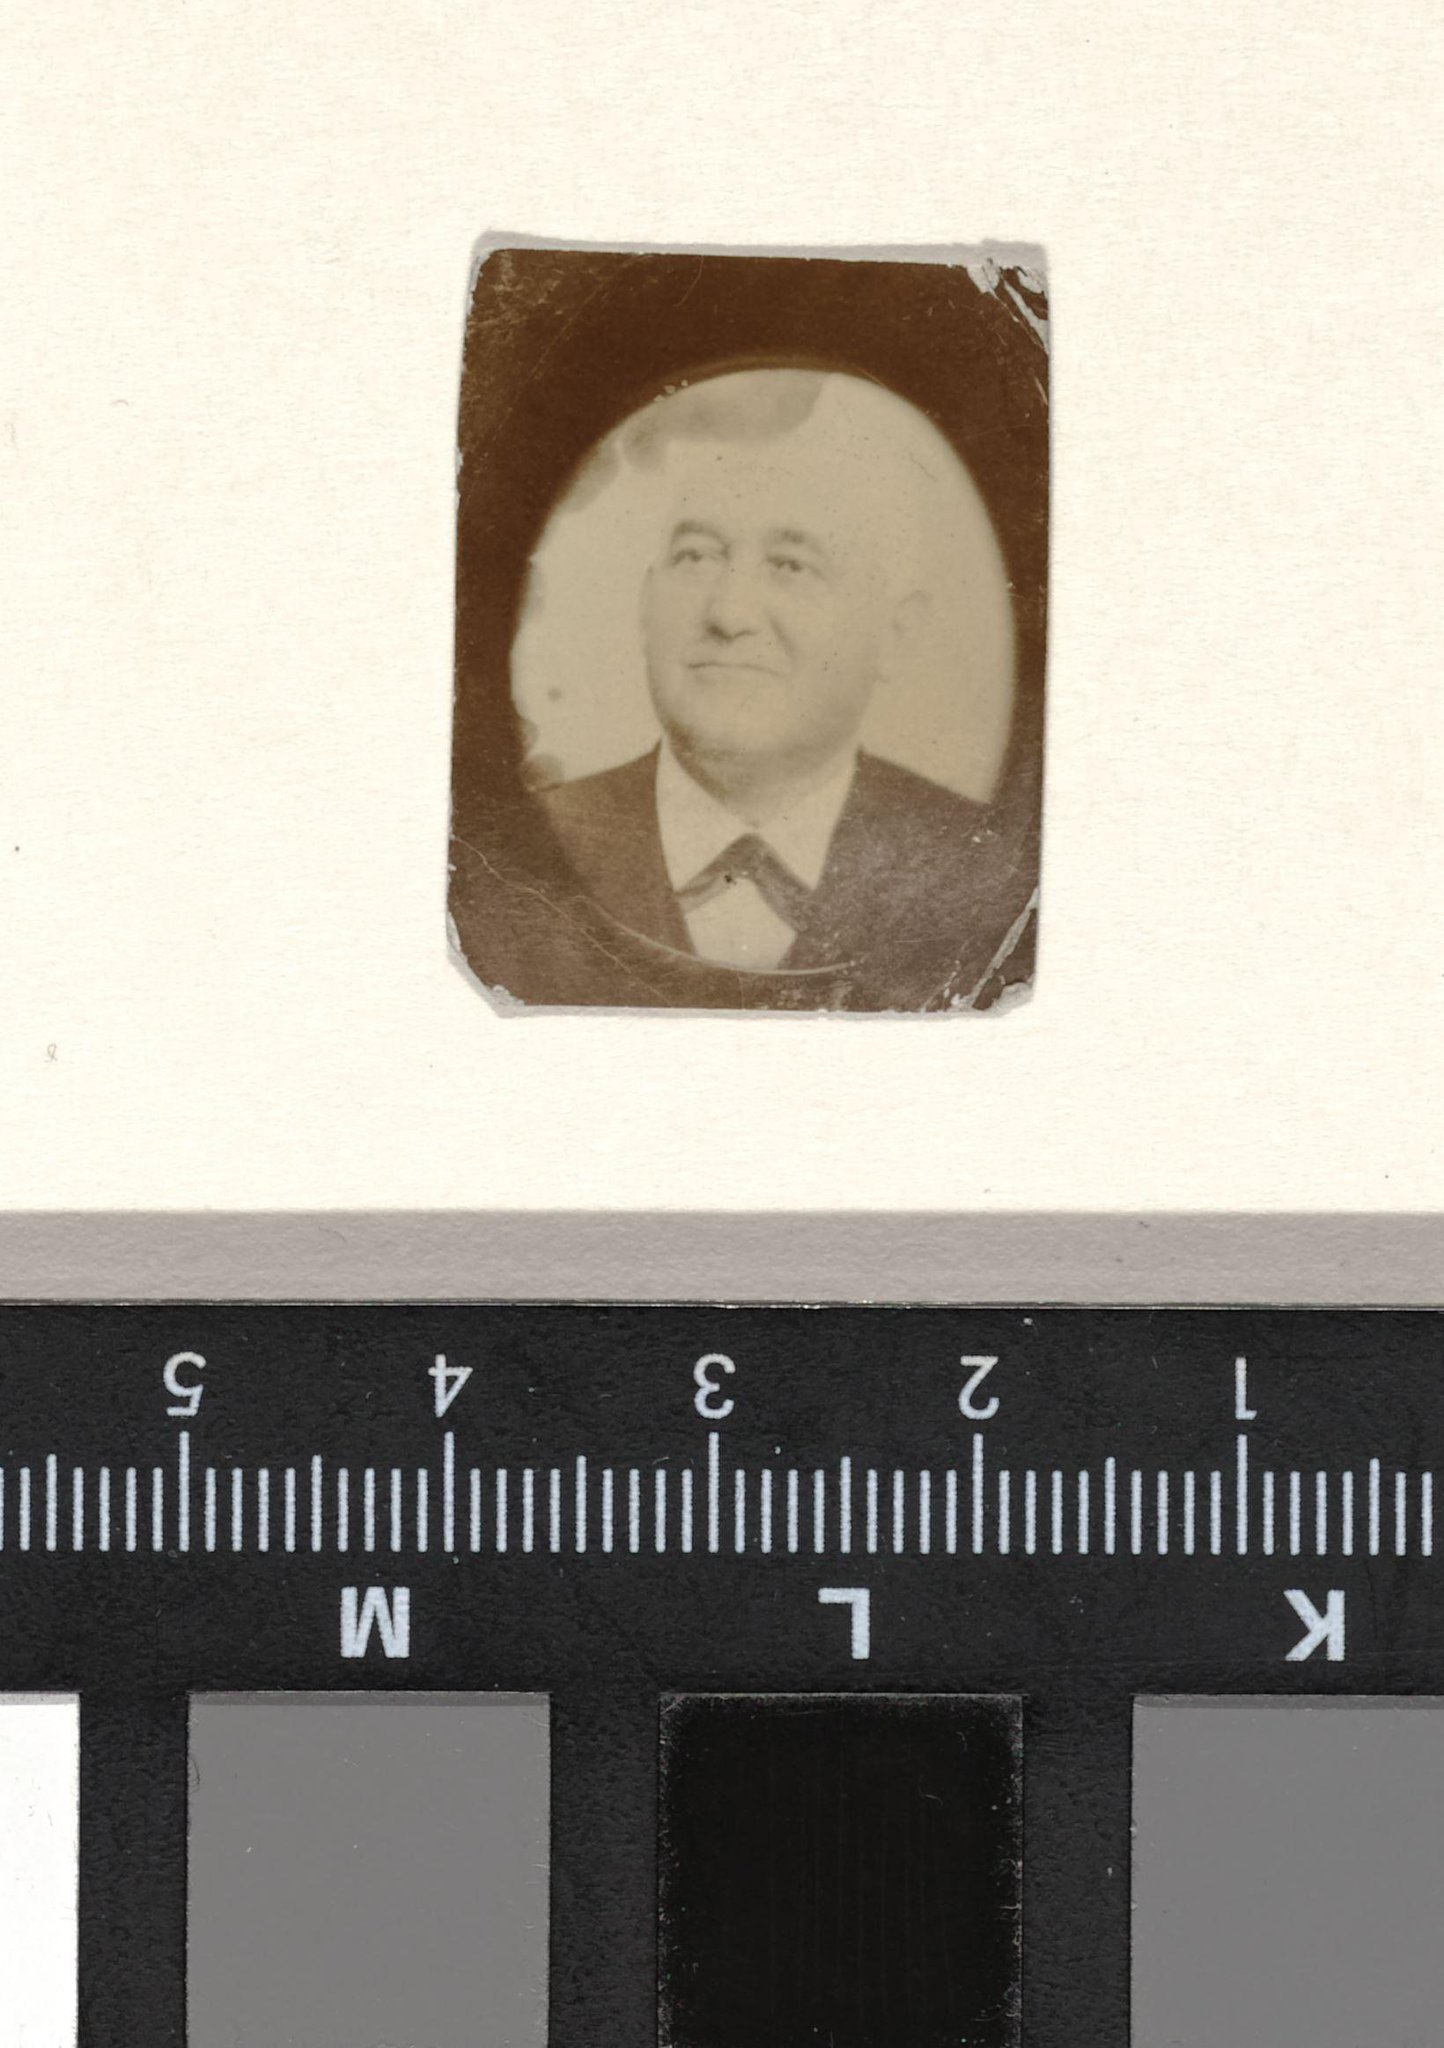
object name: photograph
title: Klein portret van een onbekende man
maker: Anonymous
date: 1860-1910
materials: photographic support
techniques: gelatin silver print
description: Klein portret van een onbekende man, in donkere kleding met wit hemd en donkere strik om zijn nek.